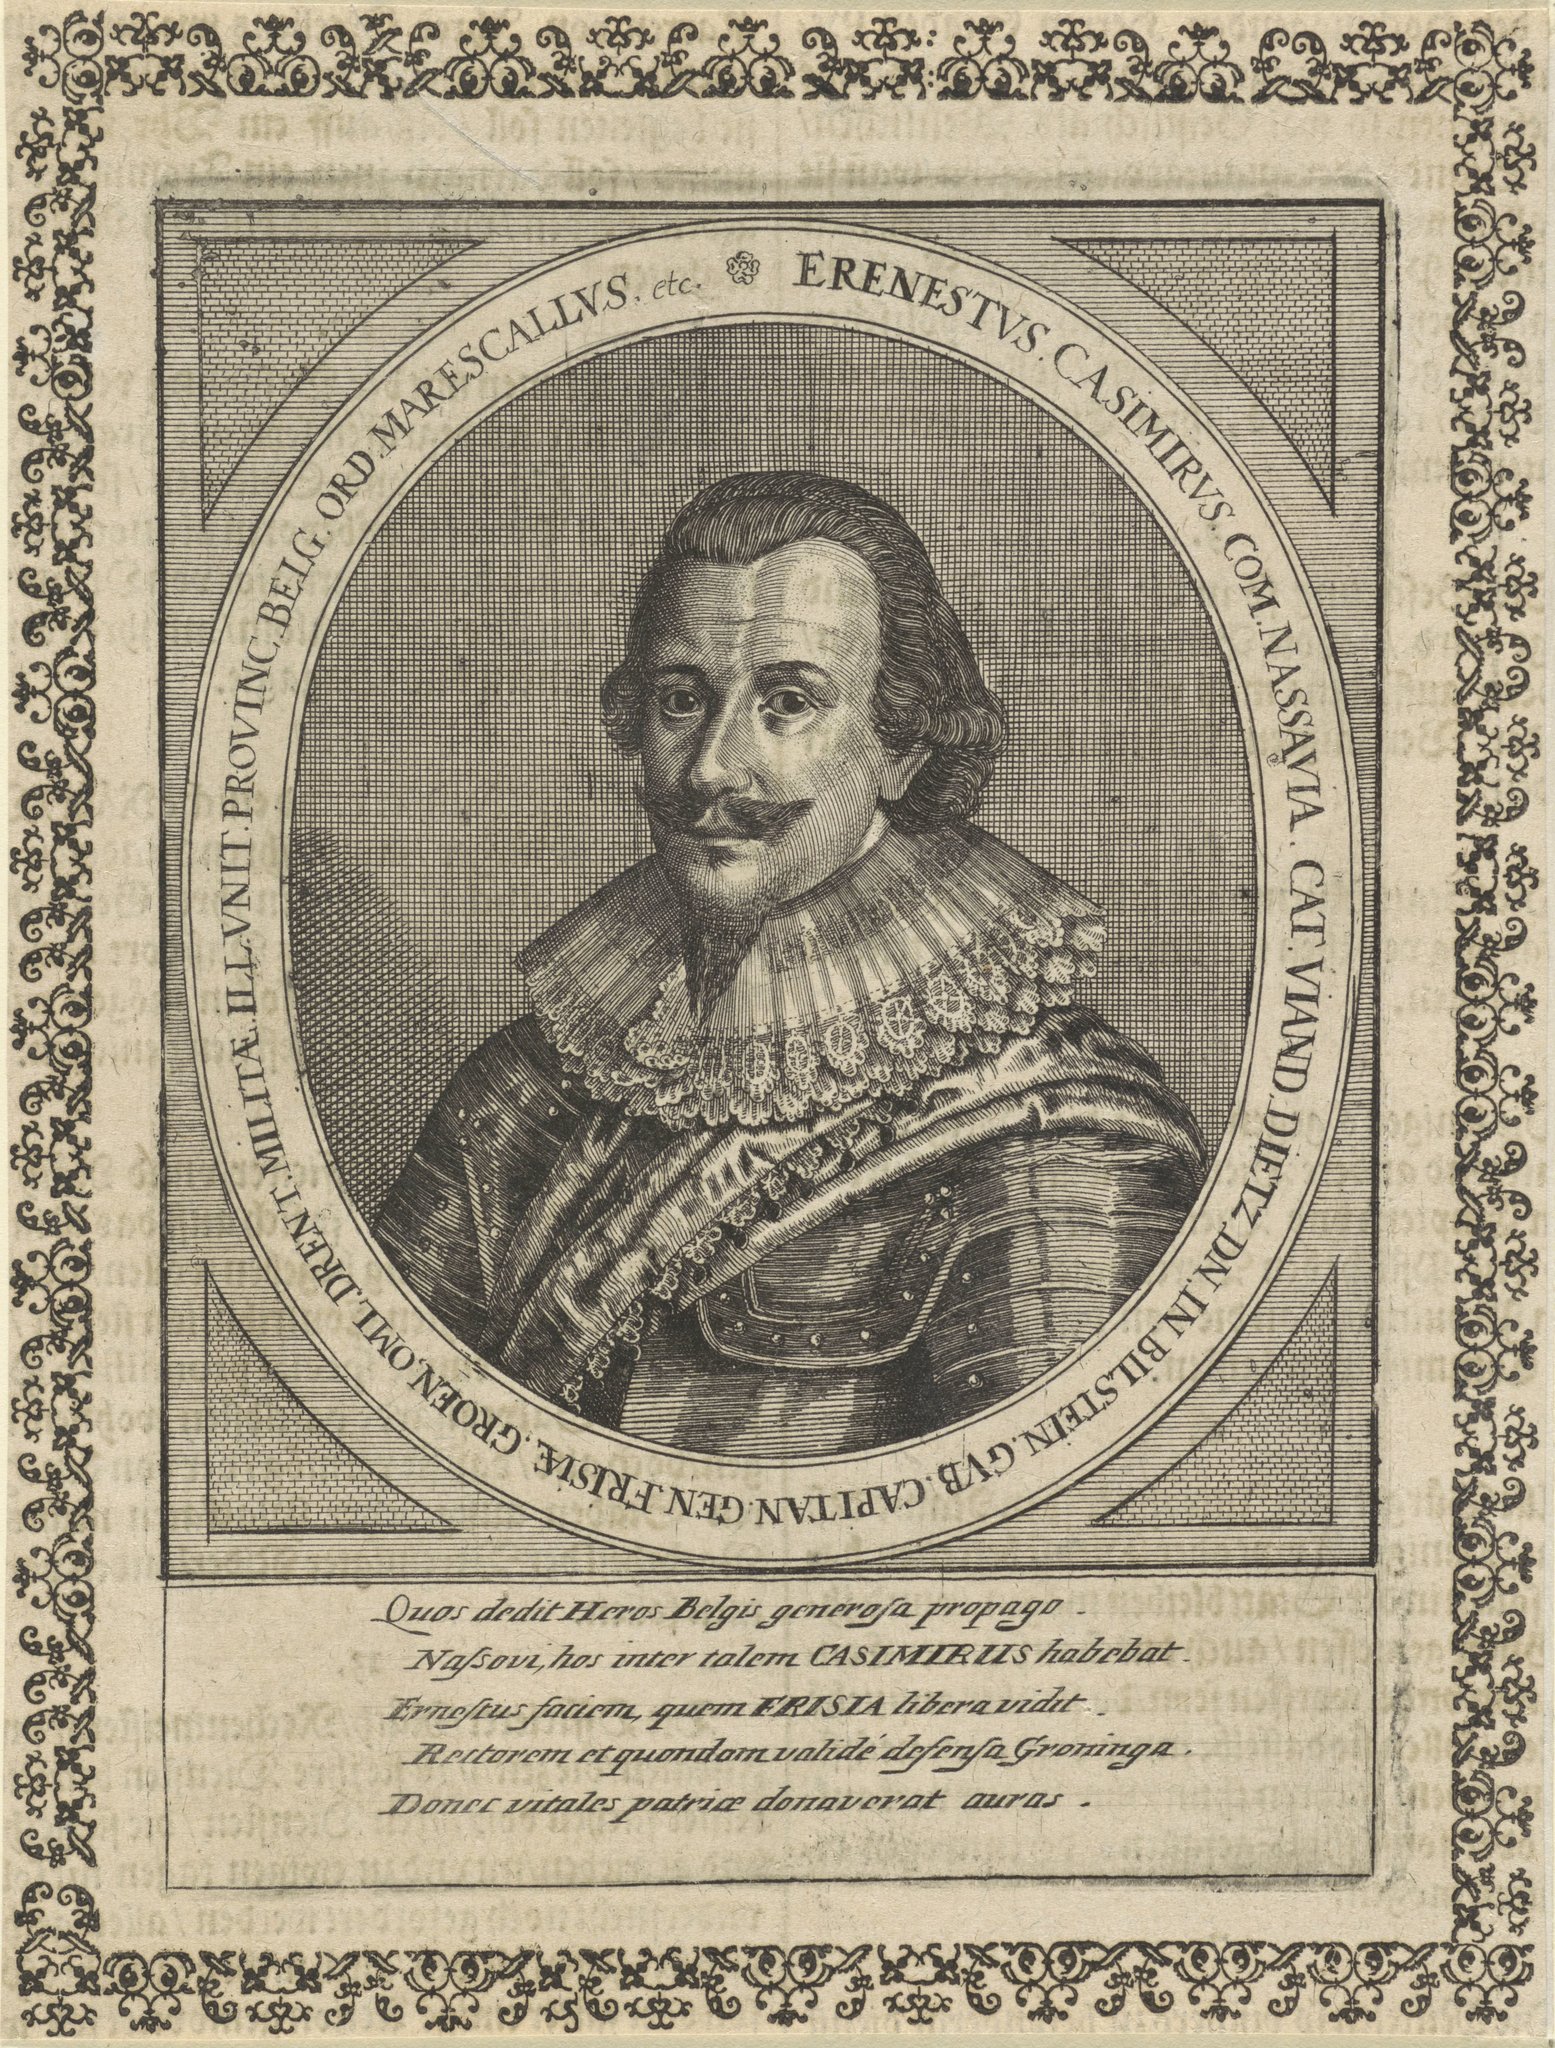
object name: book illustration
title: Portret van Ernst Casimir, graaf van Nassau-Dietz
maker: Anonymous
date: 1600-1699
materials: paper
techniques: engraving, etching, letterpress printing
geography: low countries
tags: ernst casimir graaf van nassau-dietz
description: De hier vermelde titel verwijst naar de hoogst verkregen titel van de geportretteerde, niet per se naar de titel die de geportretteerde op deze voorstelling draagt.